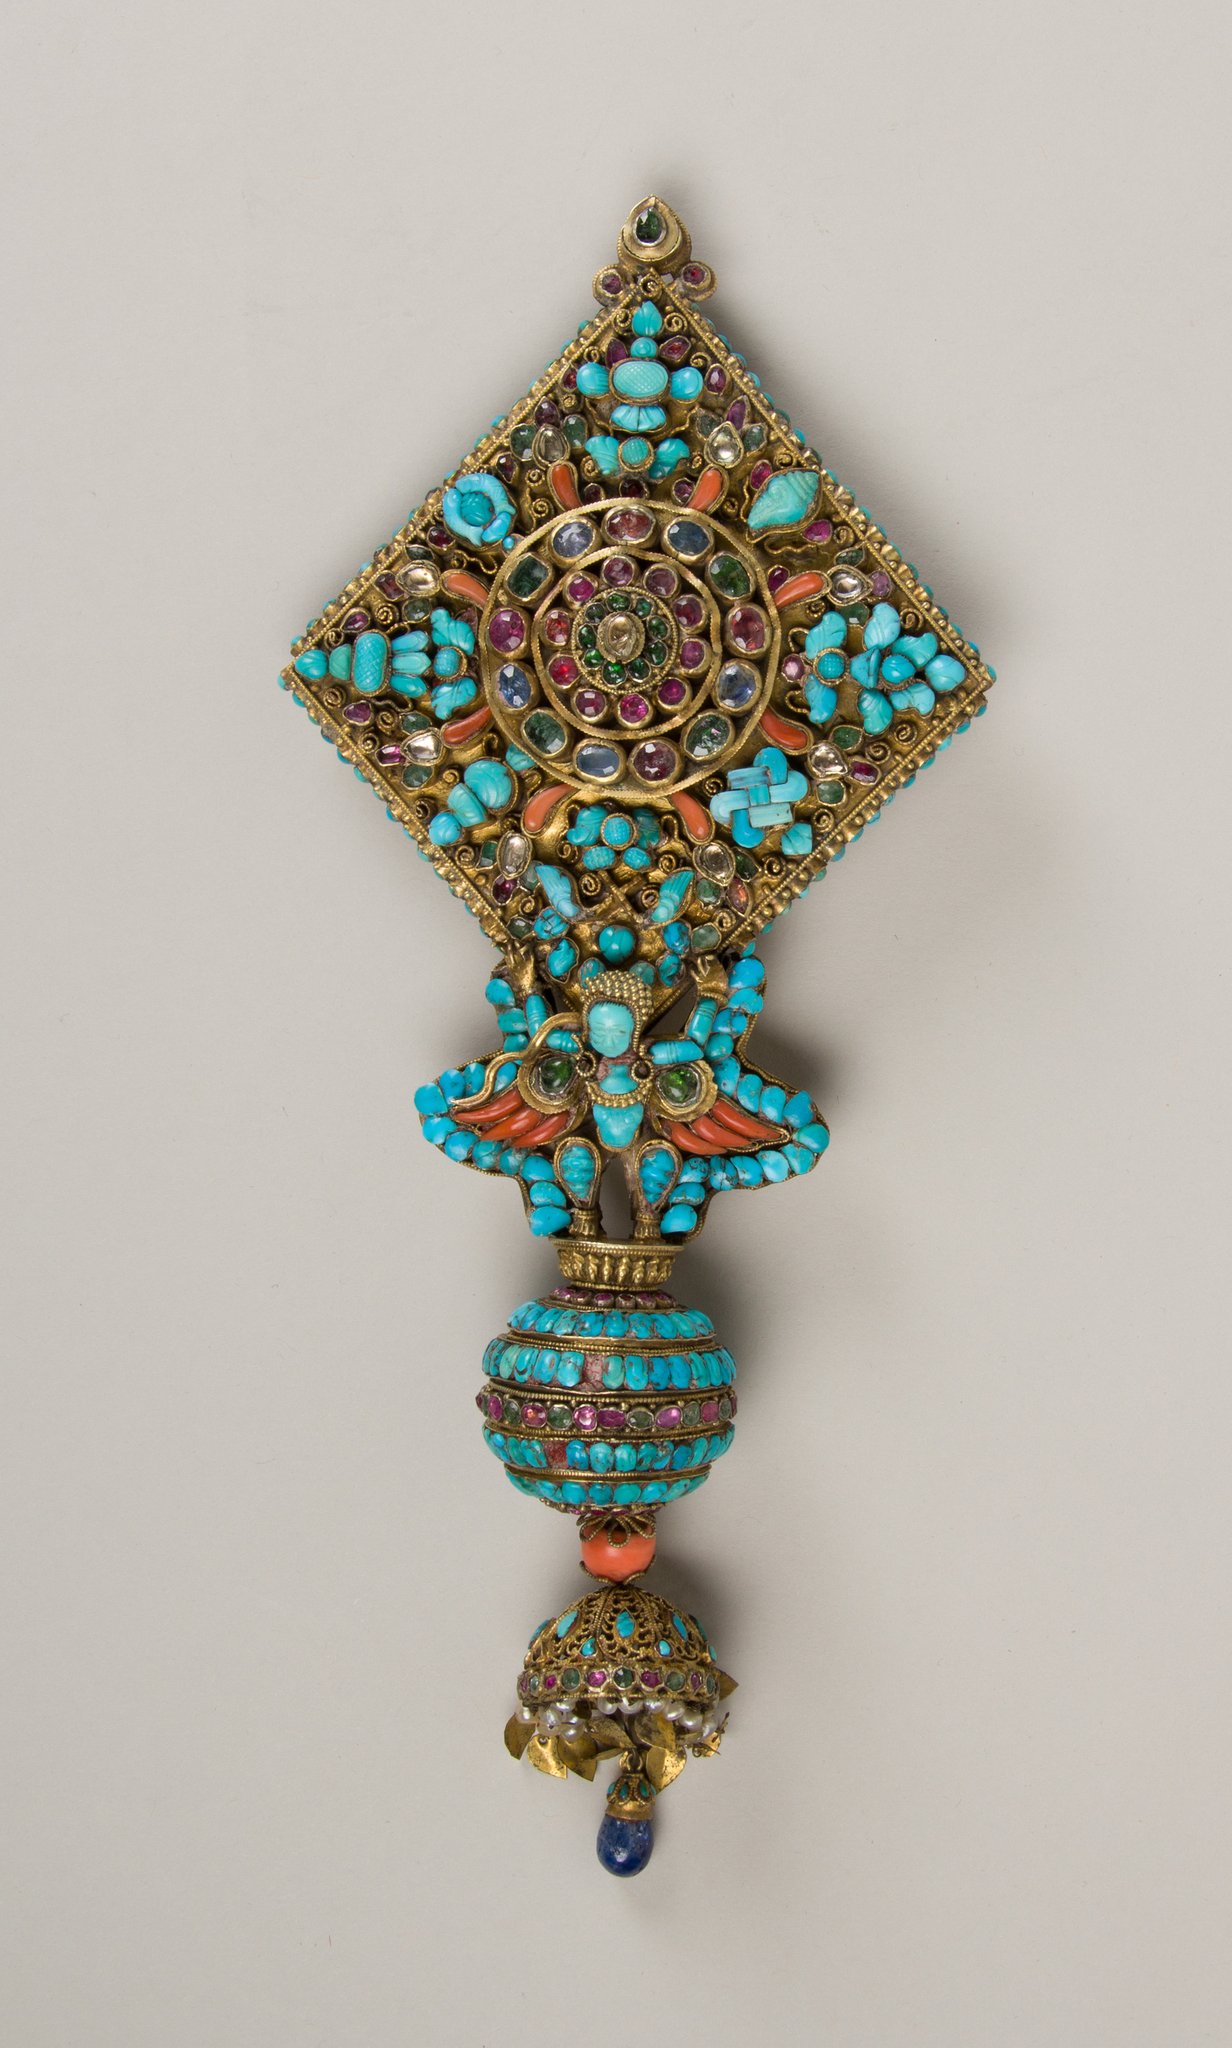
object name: ornament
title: Ear Ornament for a Deity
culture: nepali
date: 1601-1900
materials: coral, gemstone, silver gilt, lapis lazuli, mercury, pearl